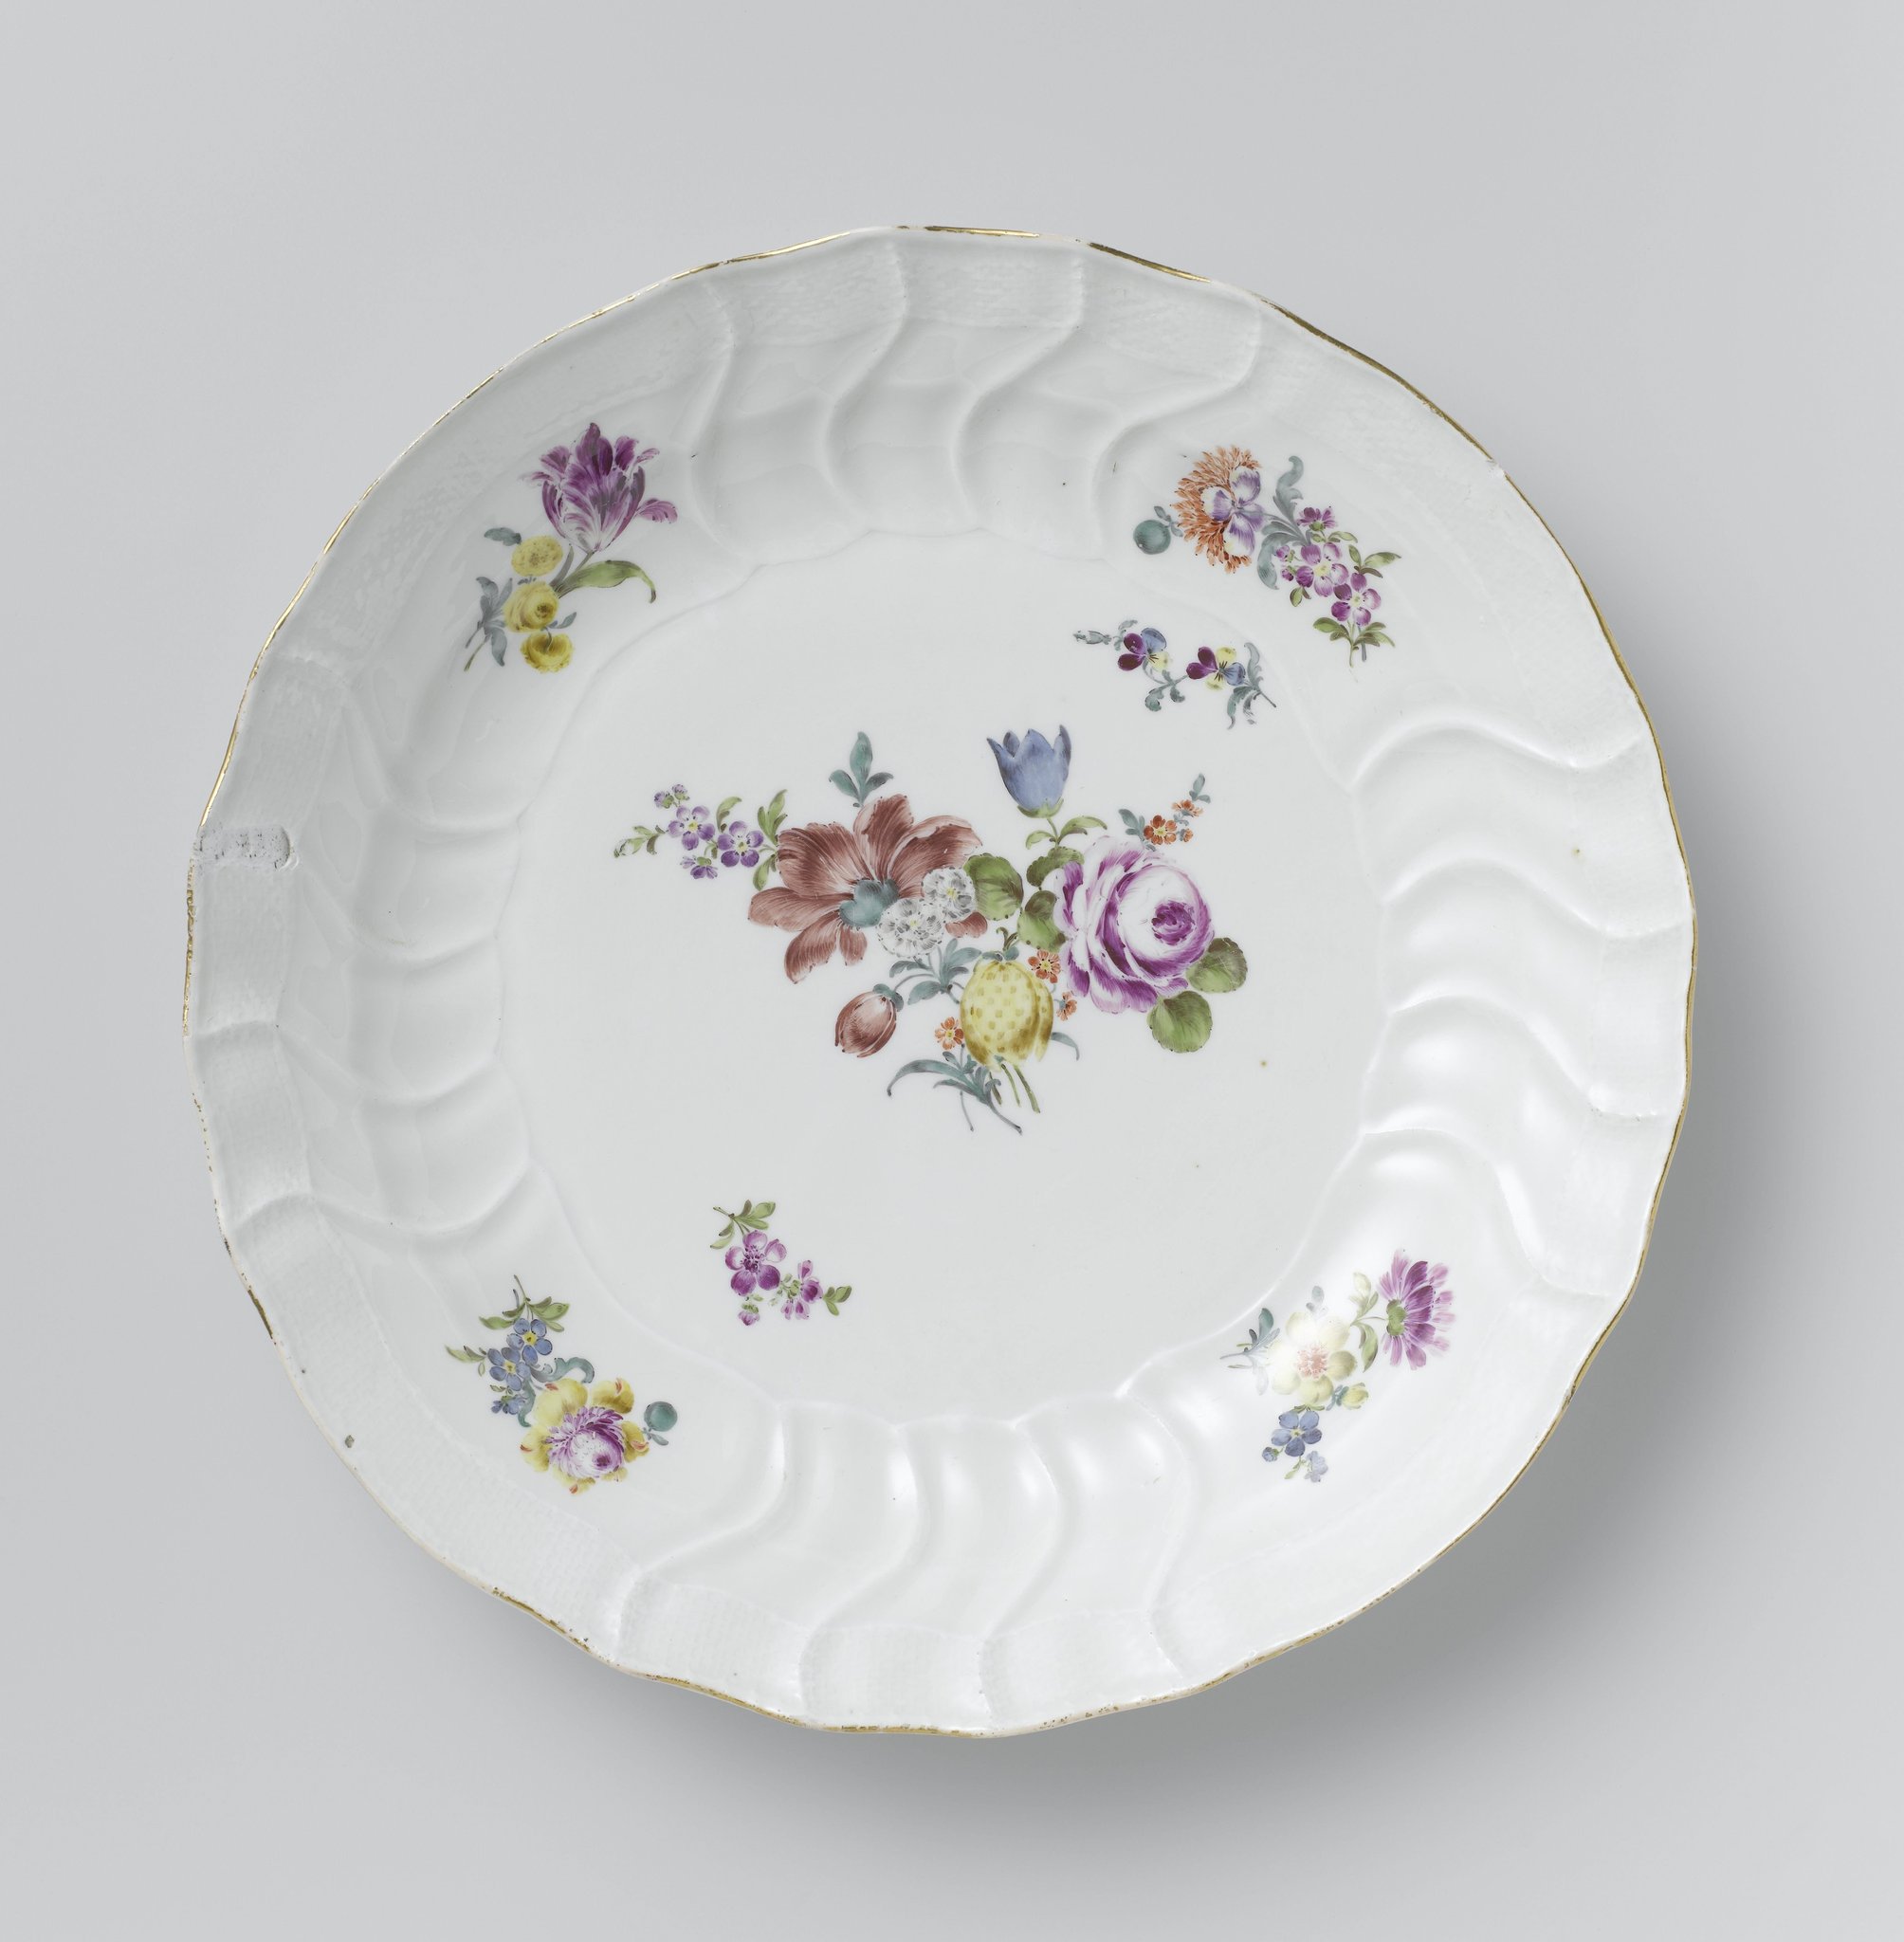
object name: eating drinking utensil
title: Schotel, veelkleurig beschilderd met Deutsche Blumen, insekten en vruchten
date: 1750-1760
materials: porcelain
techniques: painted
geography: meissen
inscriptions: factory mark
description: Ronde schotel van beschilderd porselein. De schotel is beschilderd met Deutsche Blumen, insekten en vruchten. De rand is in reliëf versierd met het Neuozier-patroon. De schotel is gemerkt en hoort bij een servies (BK-17474-1 t/m BK-17474-253).